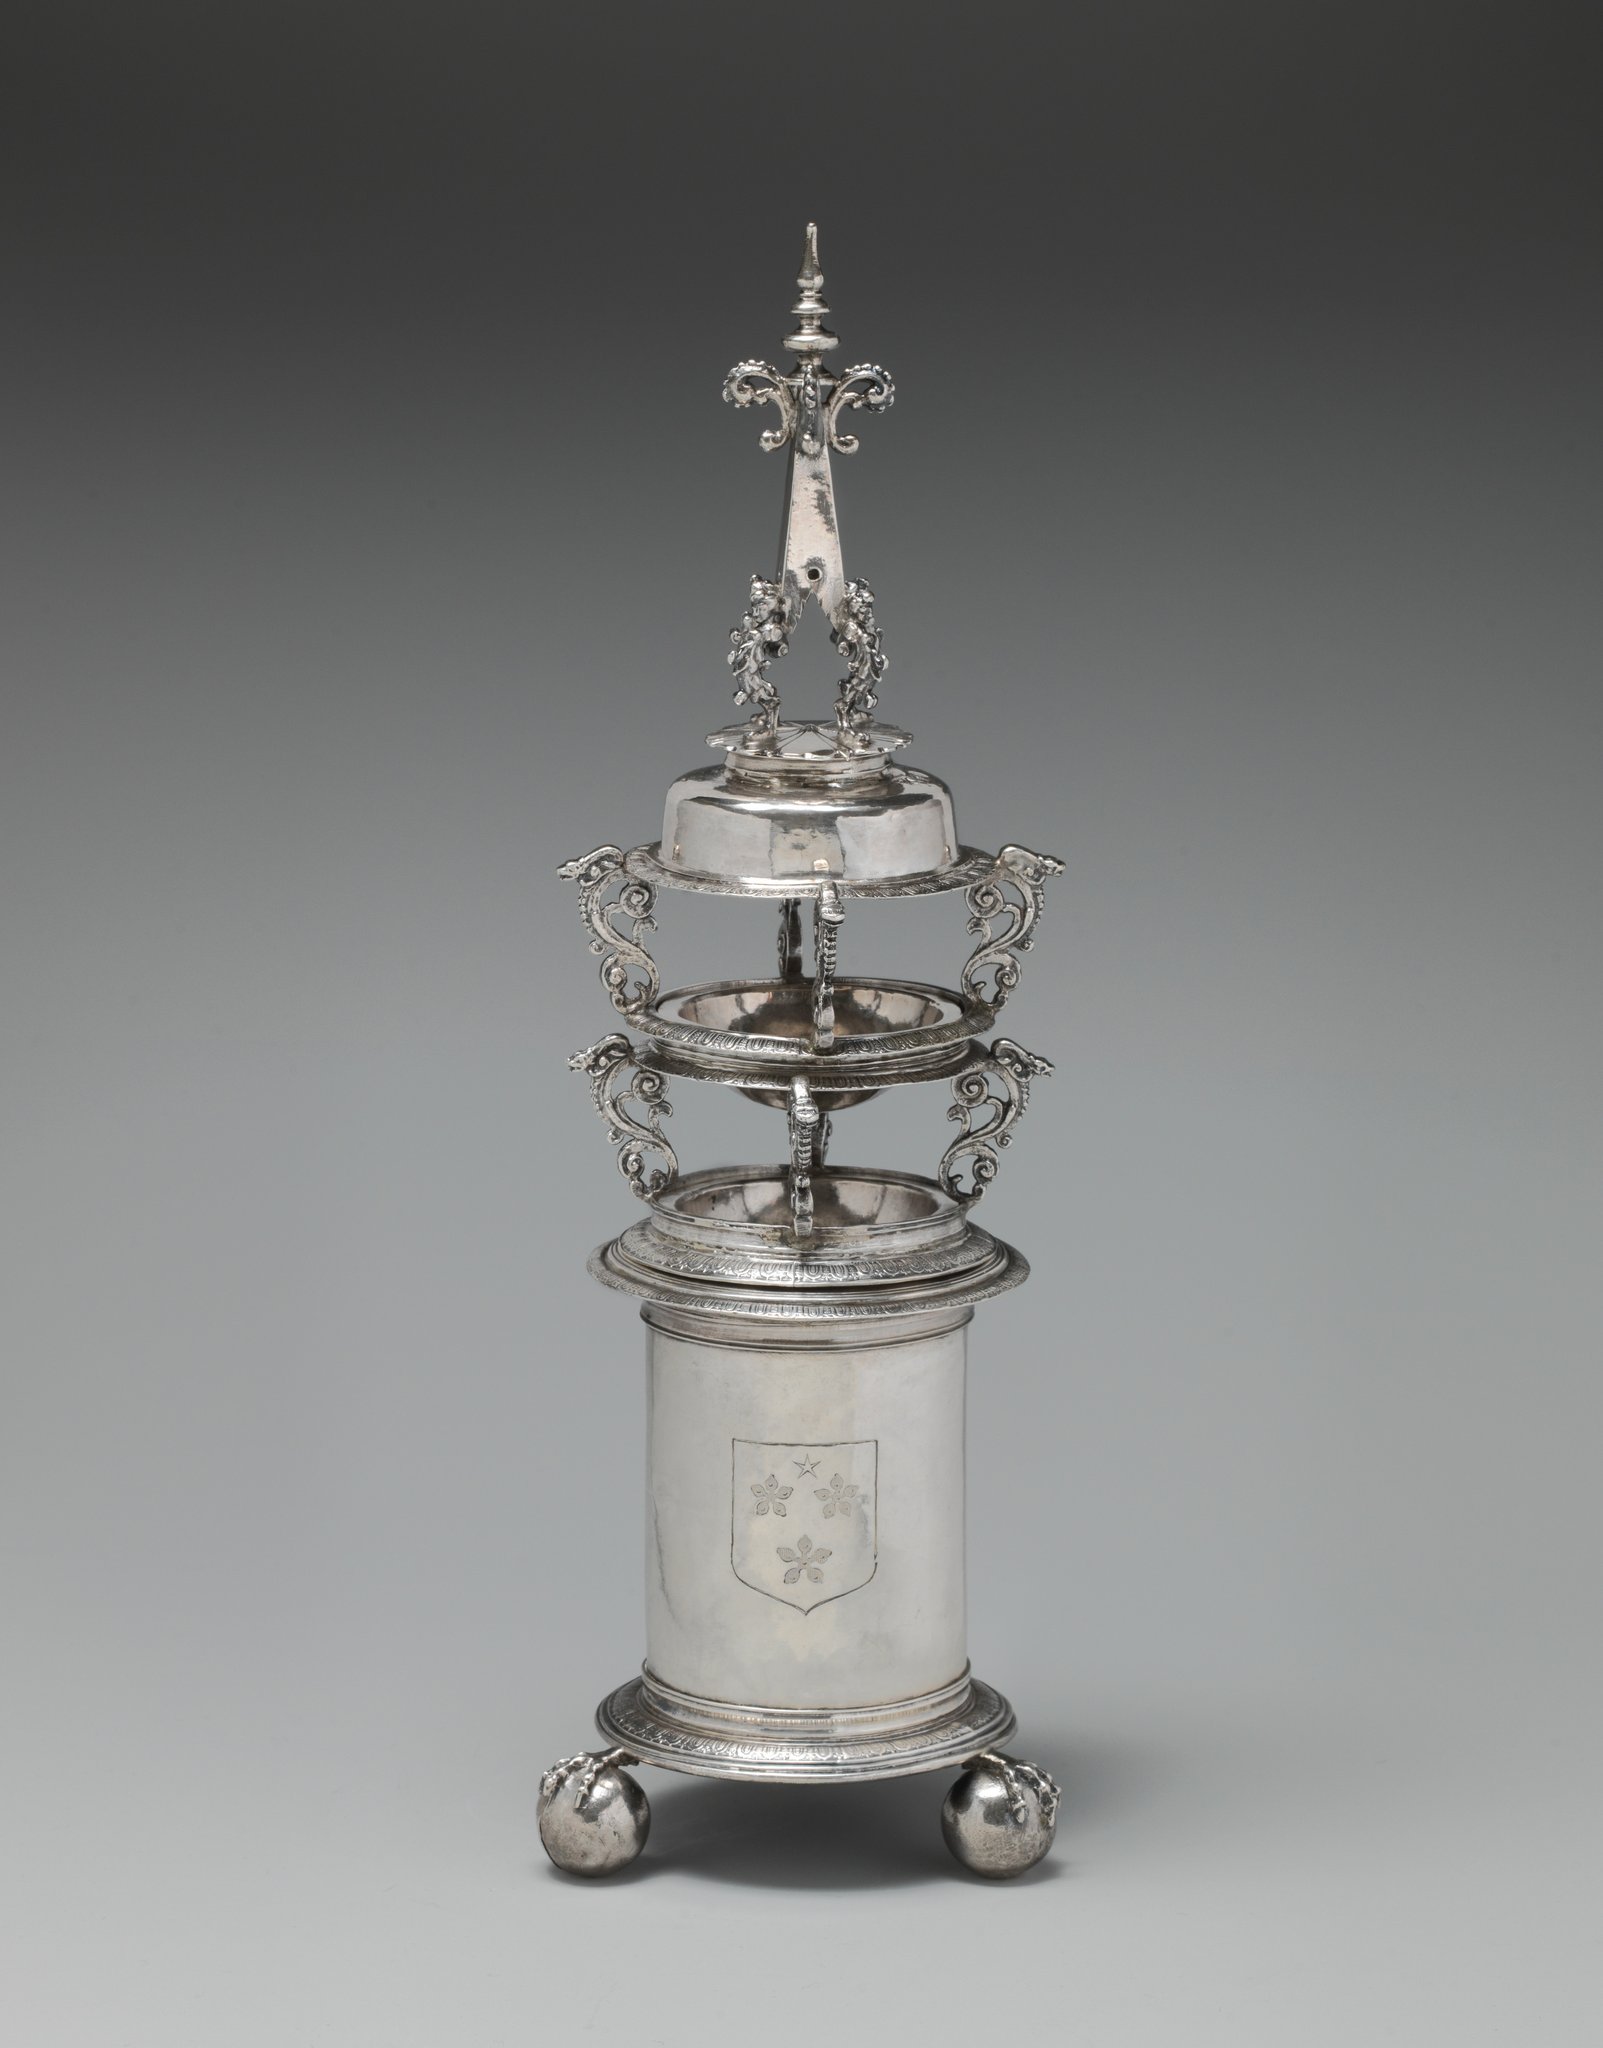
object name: double salt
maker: r. p., london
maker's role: maker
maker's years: 1615-1635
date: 1620-1621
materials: silver